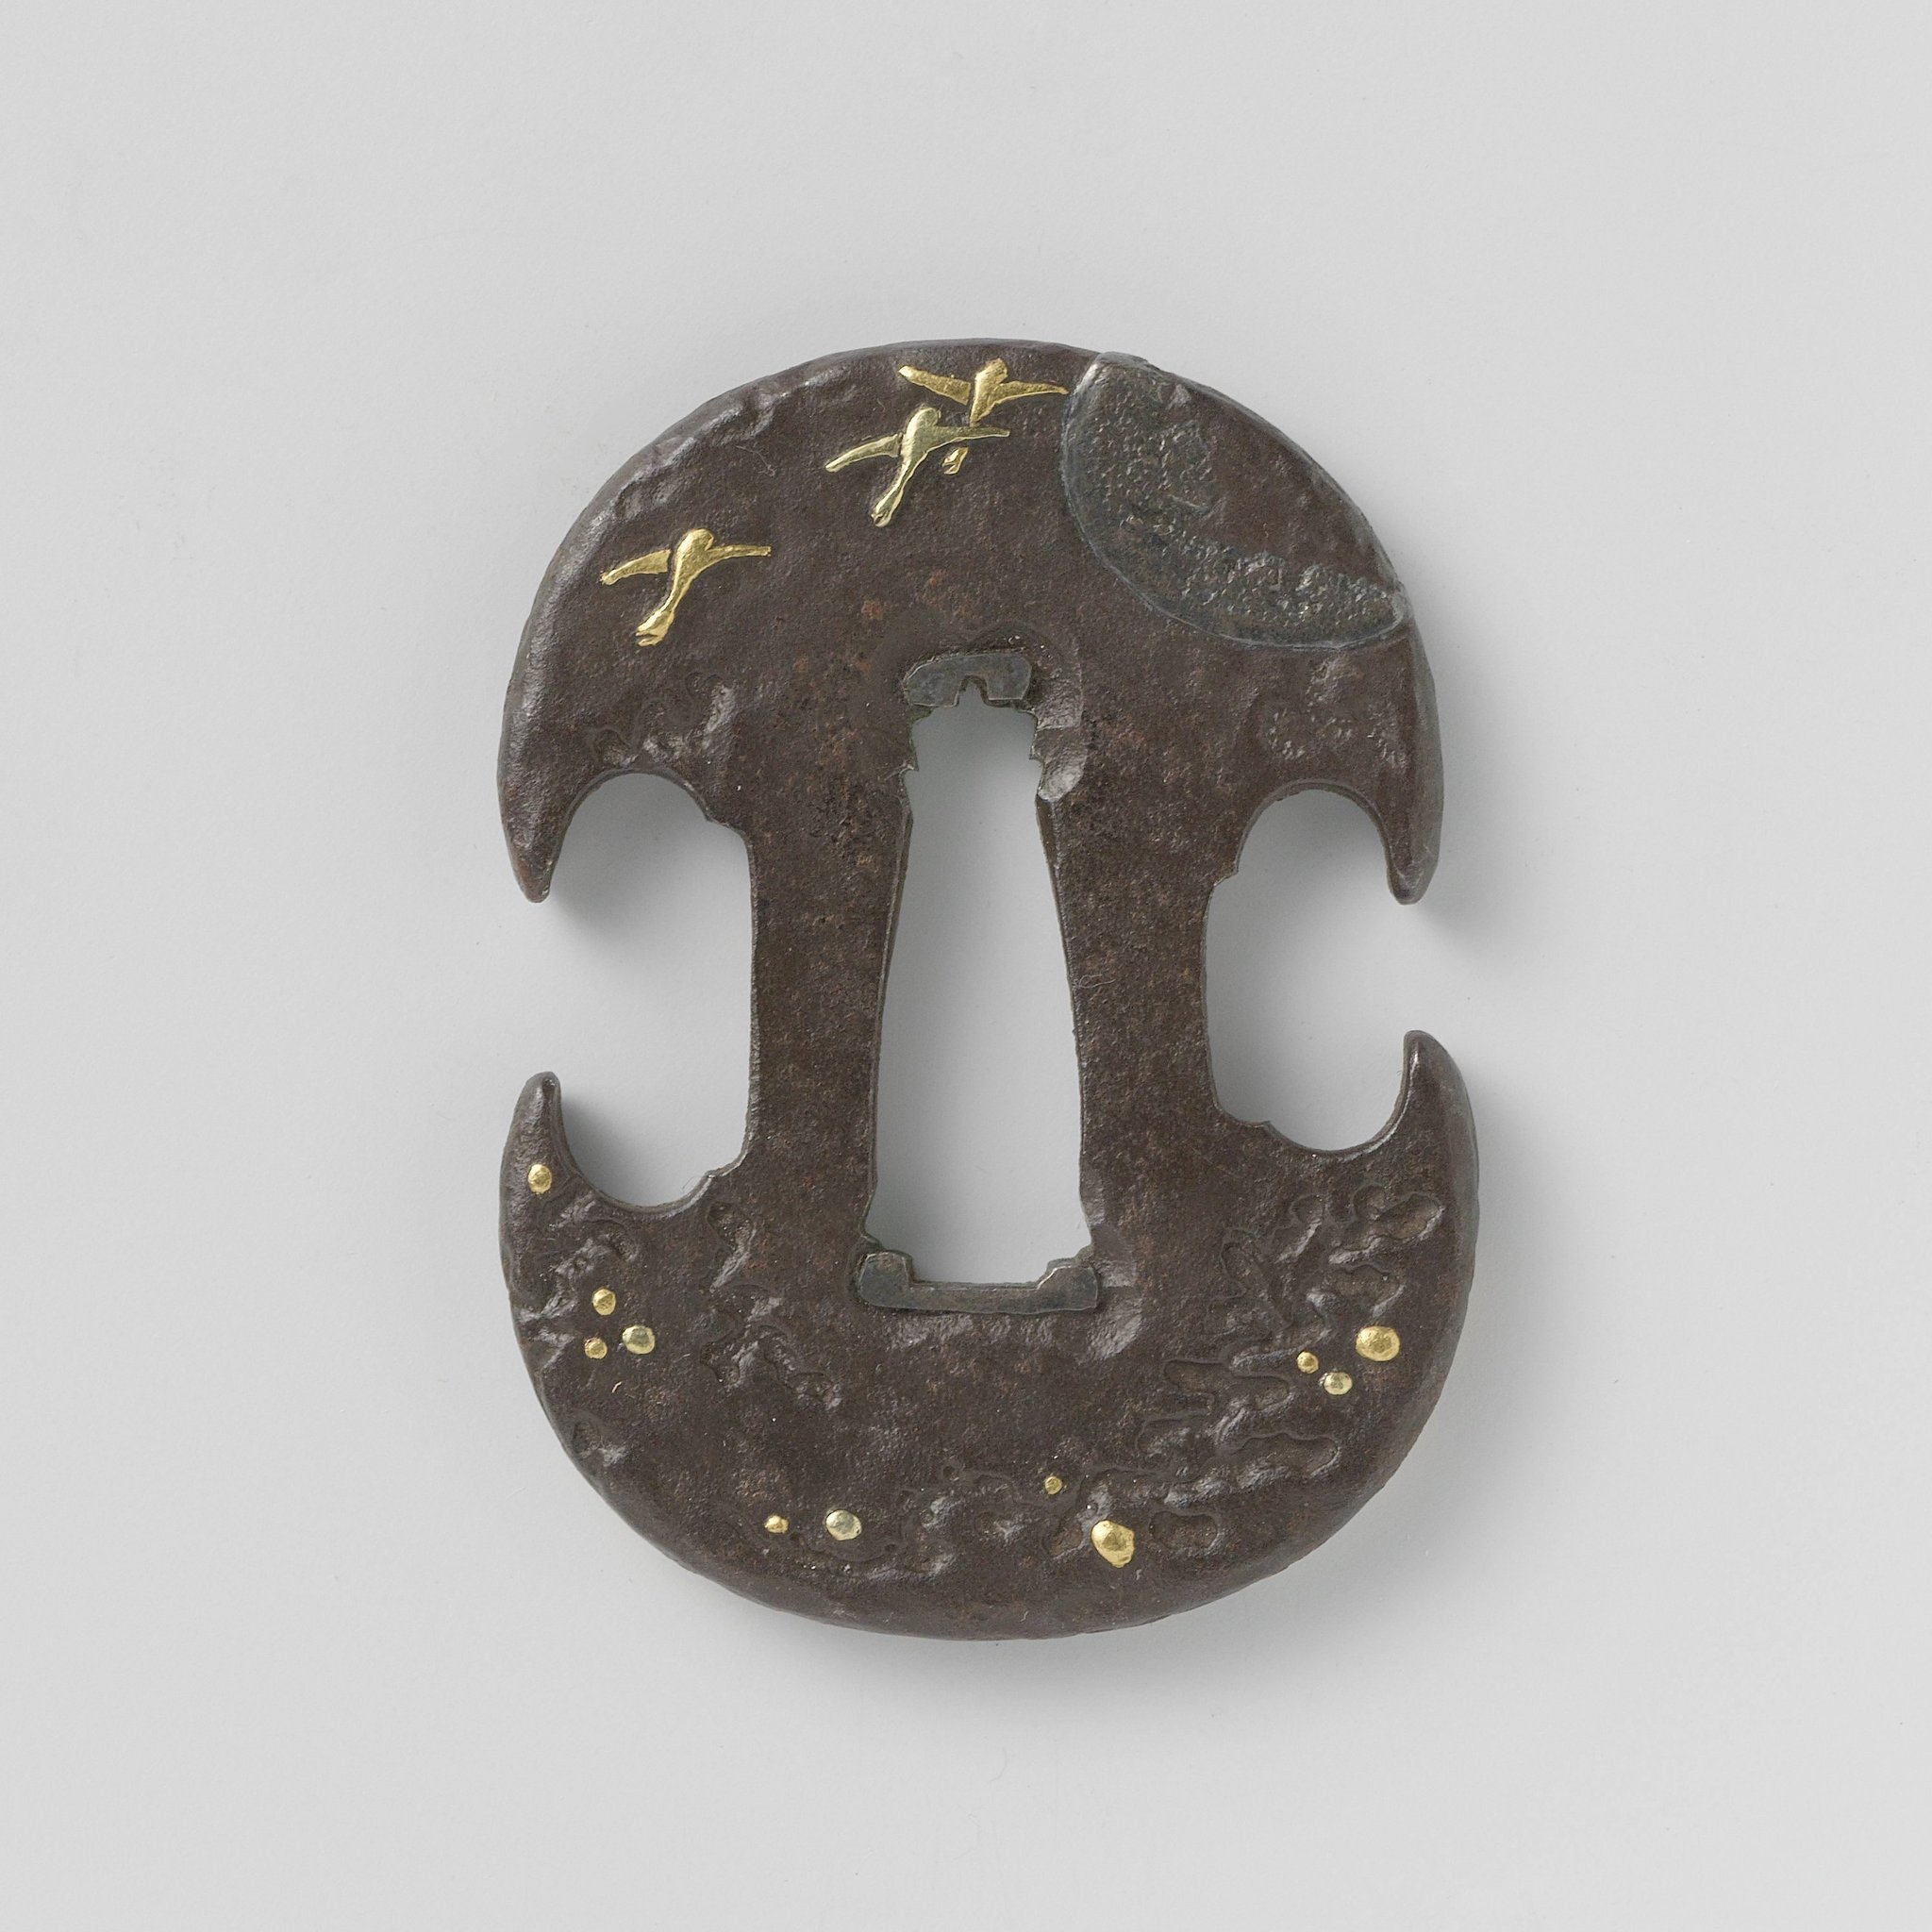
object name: tsuba, zwaardstootplaat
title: Hand guard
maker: Anonymous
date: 1700-1900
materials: gold, iron, silver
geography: japan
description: Tsuba voor een dolk met aan de voorzijde in iroe-taka-zogan ganzen en de maan boven golven; aan de achterzijde golven.